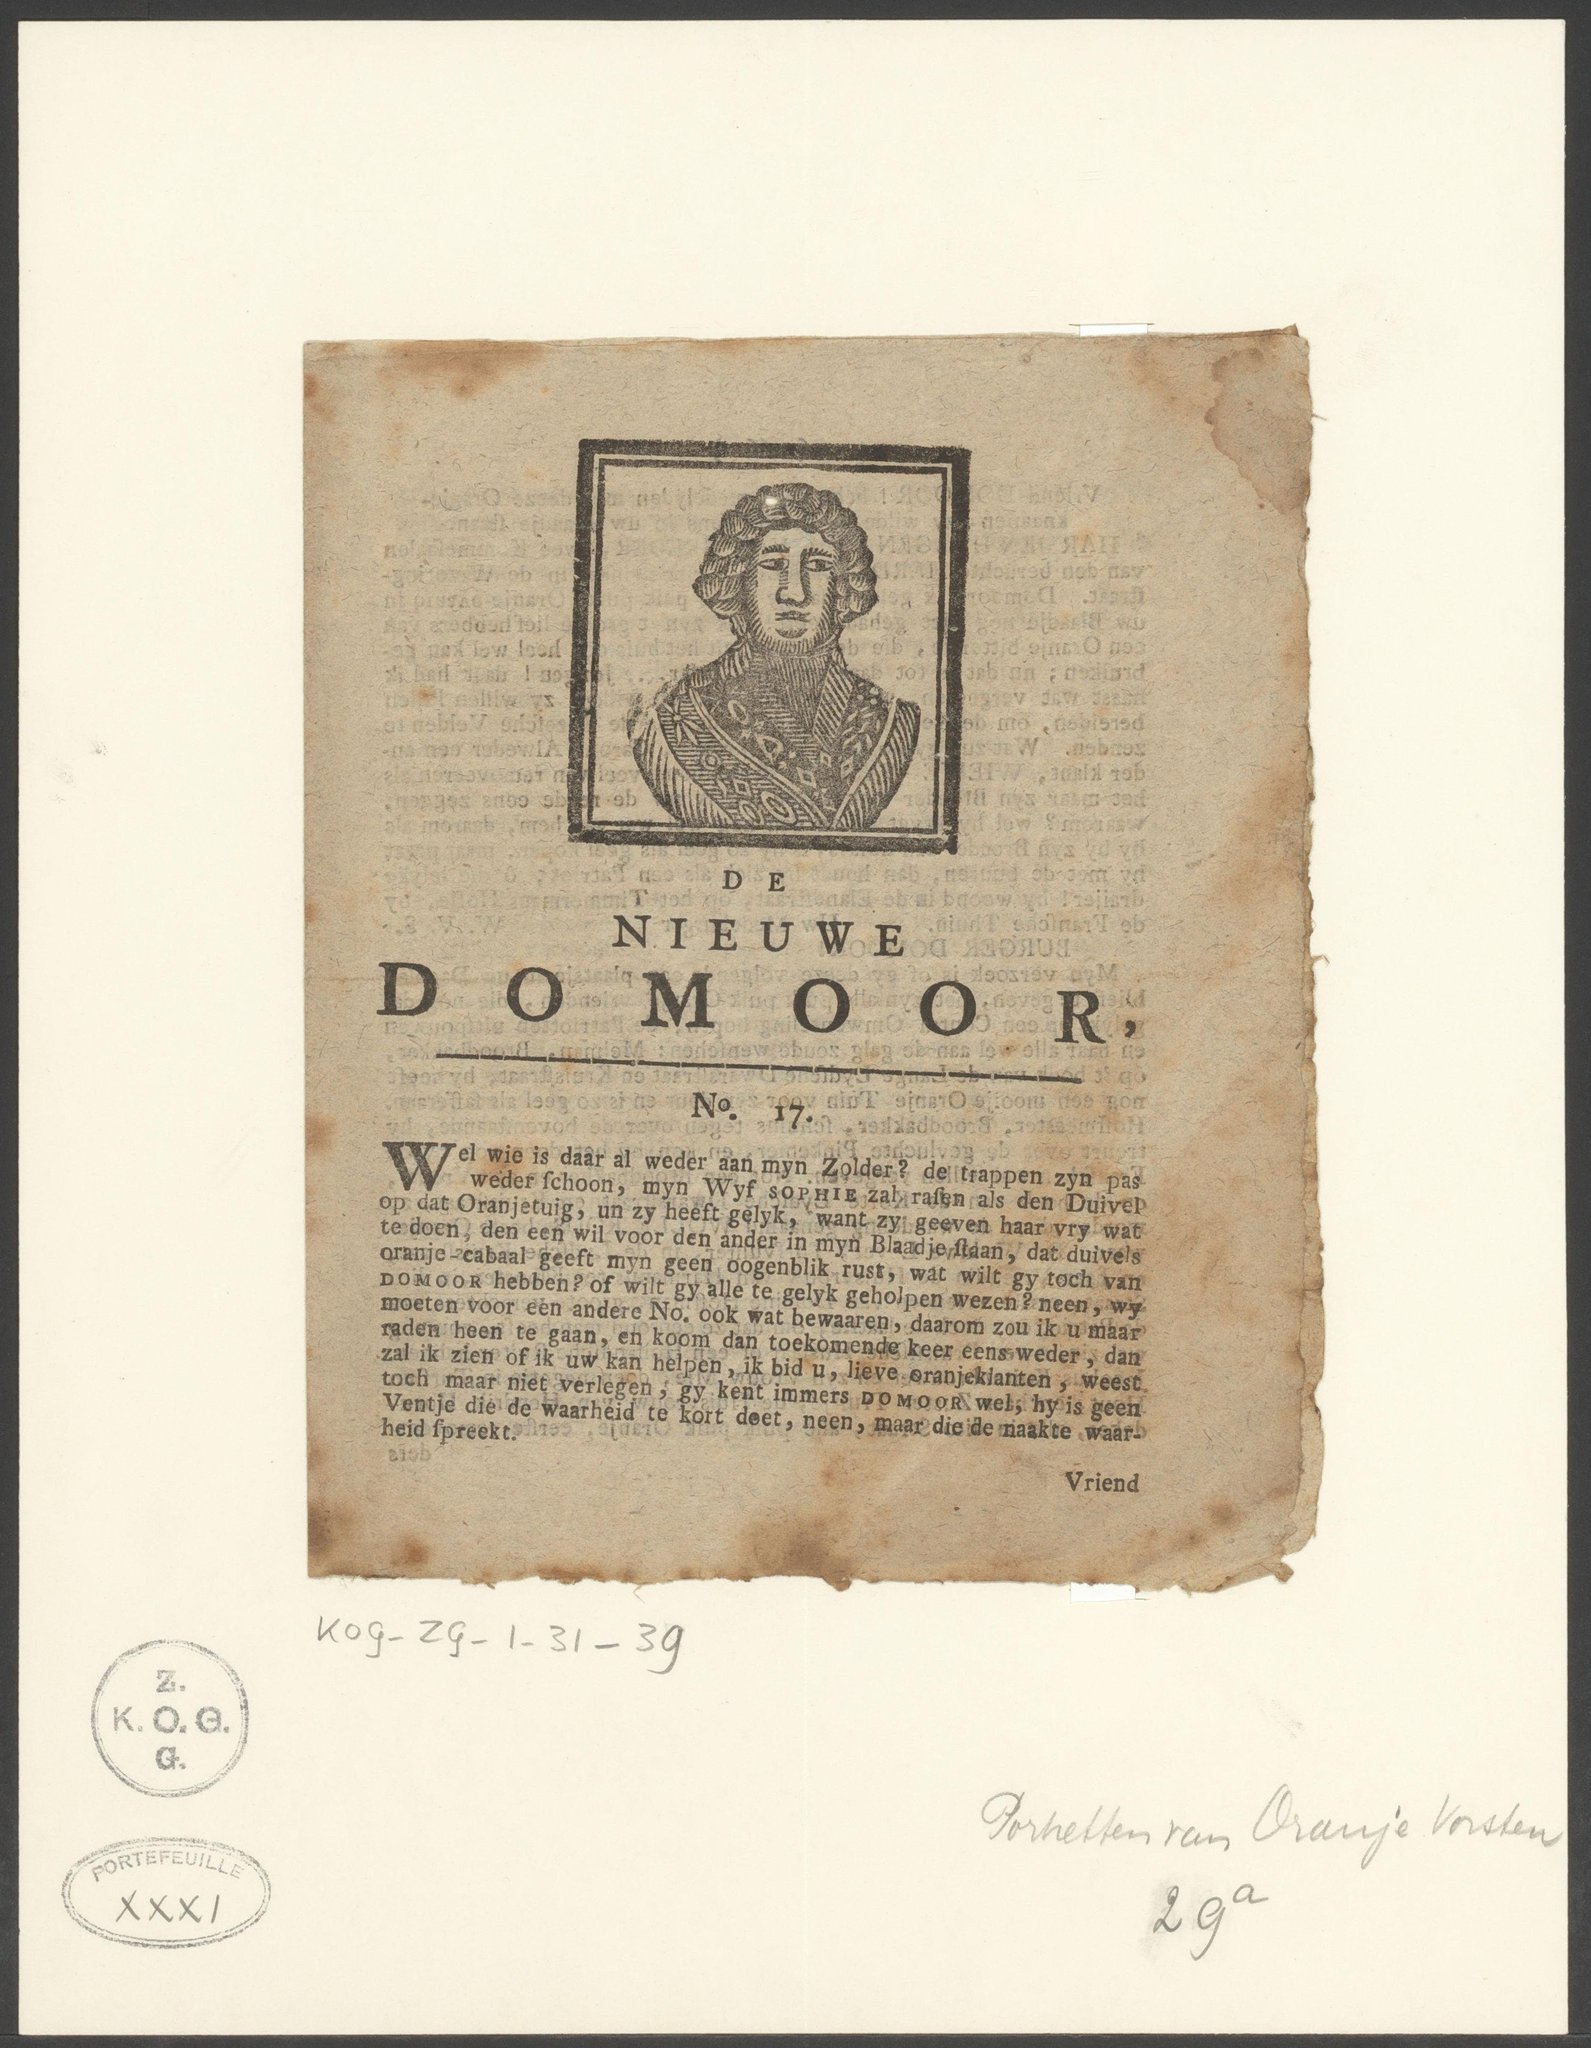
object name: text sheet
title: De nieuwe Domoor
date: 1795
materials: paper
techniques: letterpress printing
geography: amsterdam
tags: chest, bust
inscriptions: stamp, collector's mark: Lugt 1641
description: De Nieuwe Domoor is een blad met roddels dat iedere woensdag en vrijdag voor drie duiten uitgegeven werd. In de tekst wordt afgegeven op orangisten. Genummerd: No. 17. Onderwerpsrubrieken binnen de Atlas Zeden en Gewoonten: Portretten, Portretten van Vorsten uit het huis van Oranje, Regeerende Vorsten, Stadhouders van Holland, Zeeland en West-Friesland.